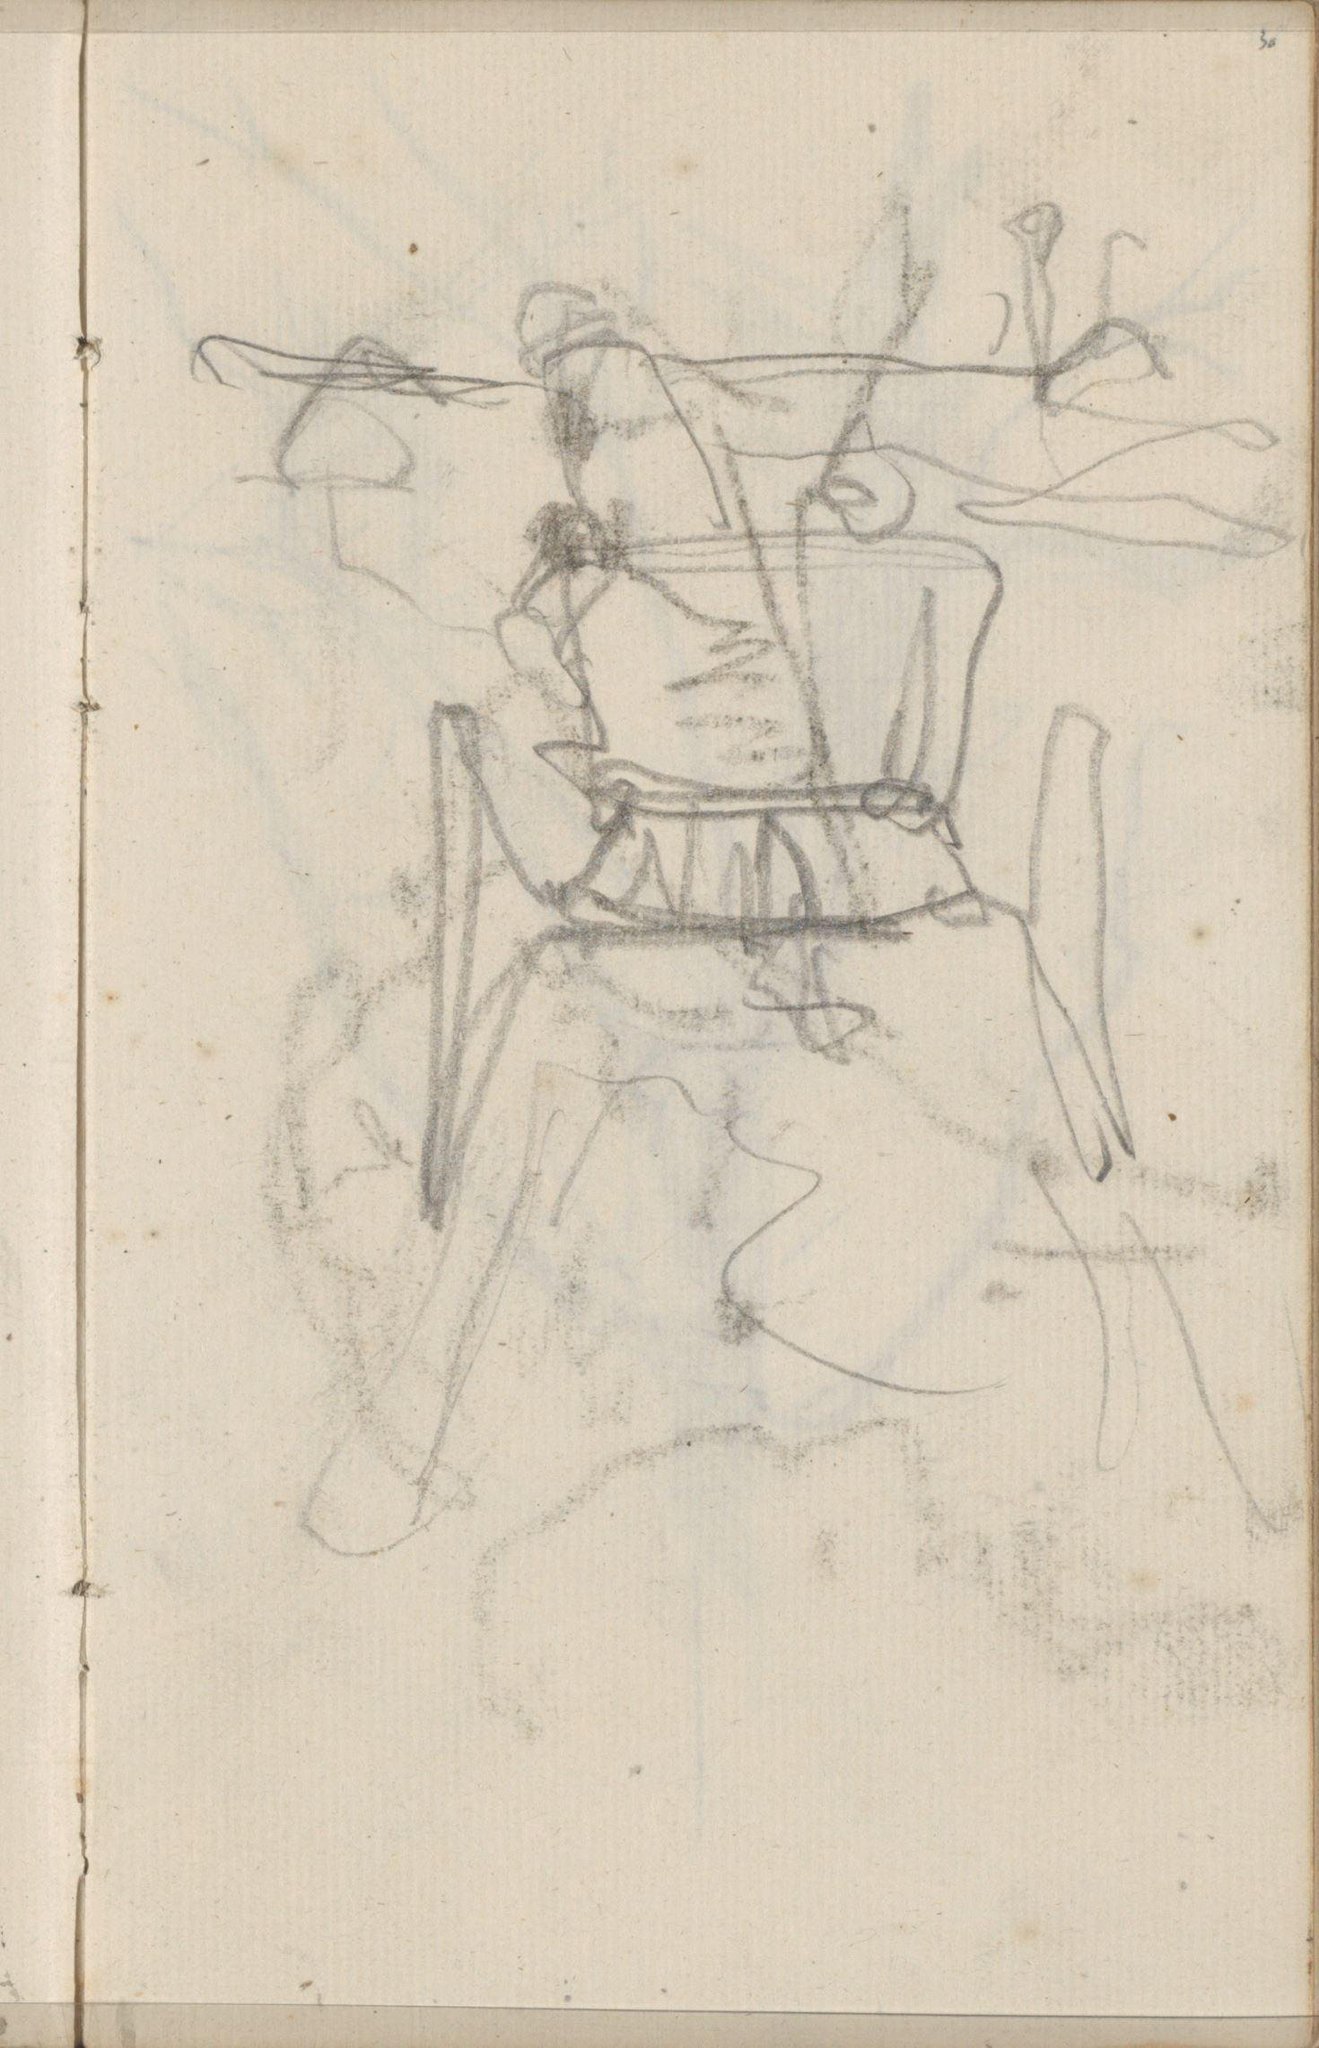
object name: sketchbook leaf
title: Rijtuig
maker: george hendrik breitner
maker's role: draughtsman, painter, print maker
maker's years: 1857-1923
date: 1880-1882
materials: paper, pencil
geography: scheveningen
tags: four-wheeled, animal-drawn vehicle, e.g.: cab, carriage, coach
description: Pagina 30 uit een schetsboek met 31 bladen.